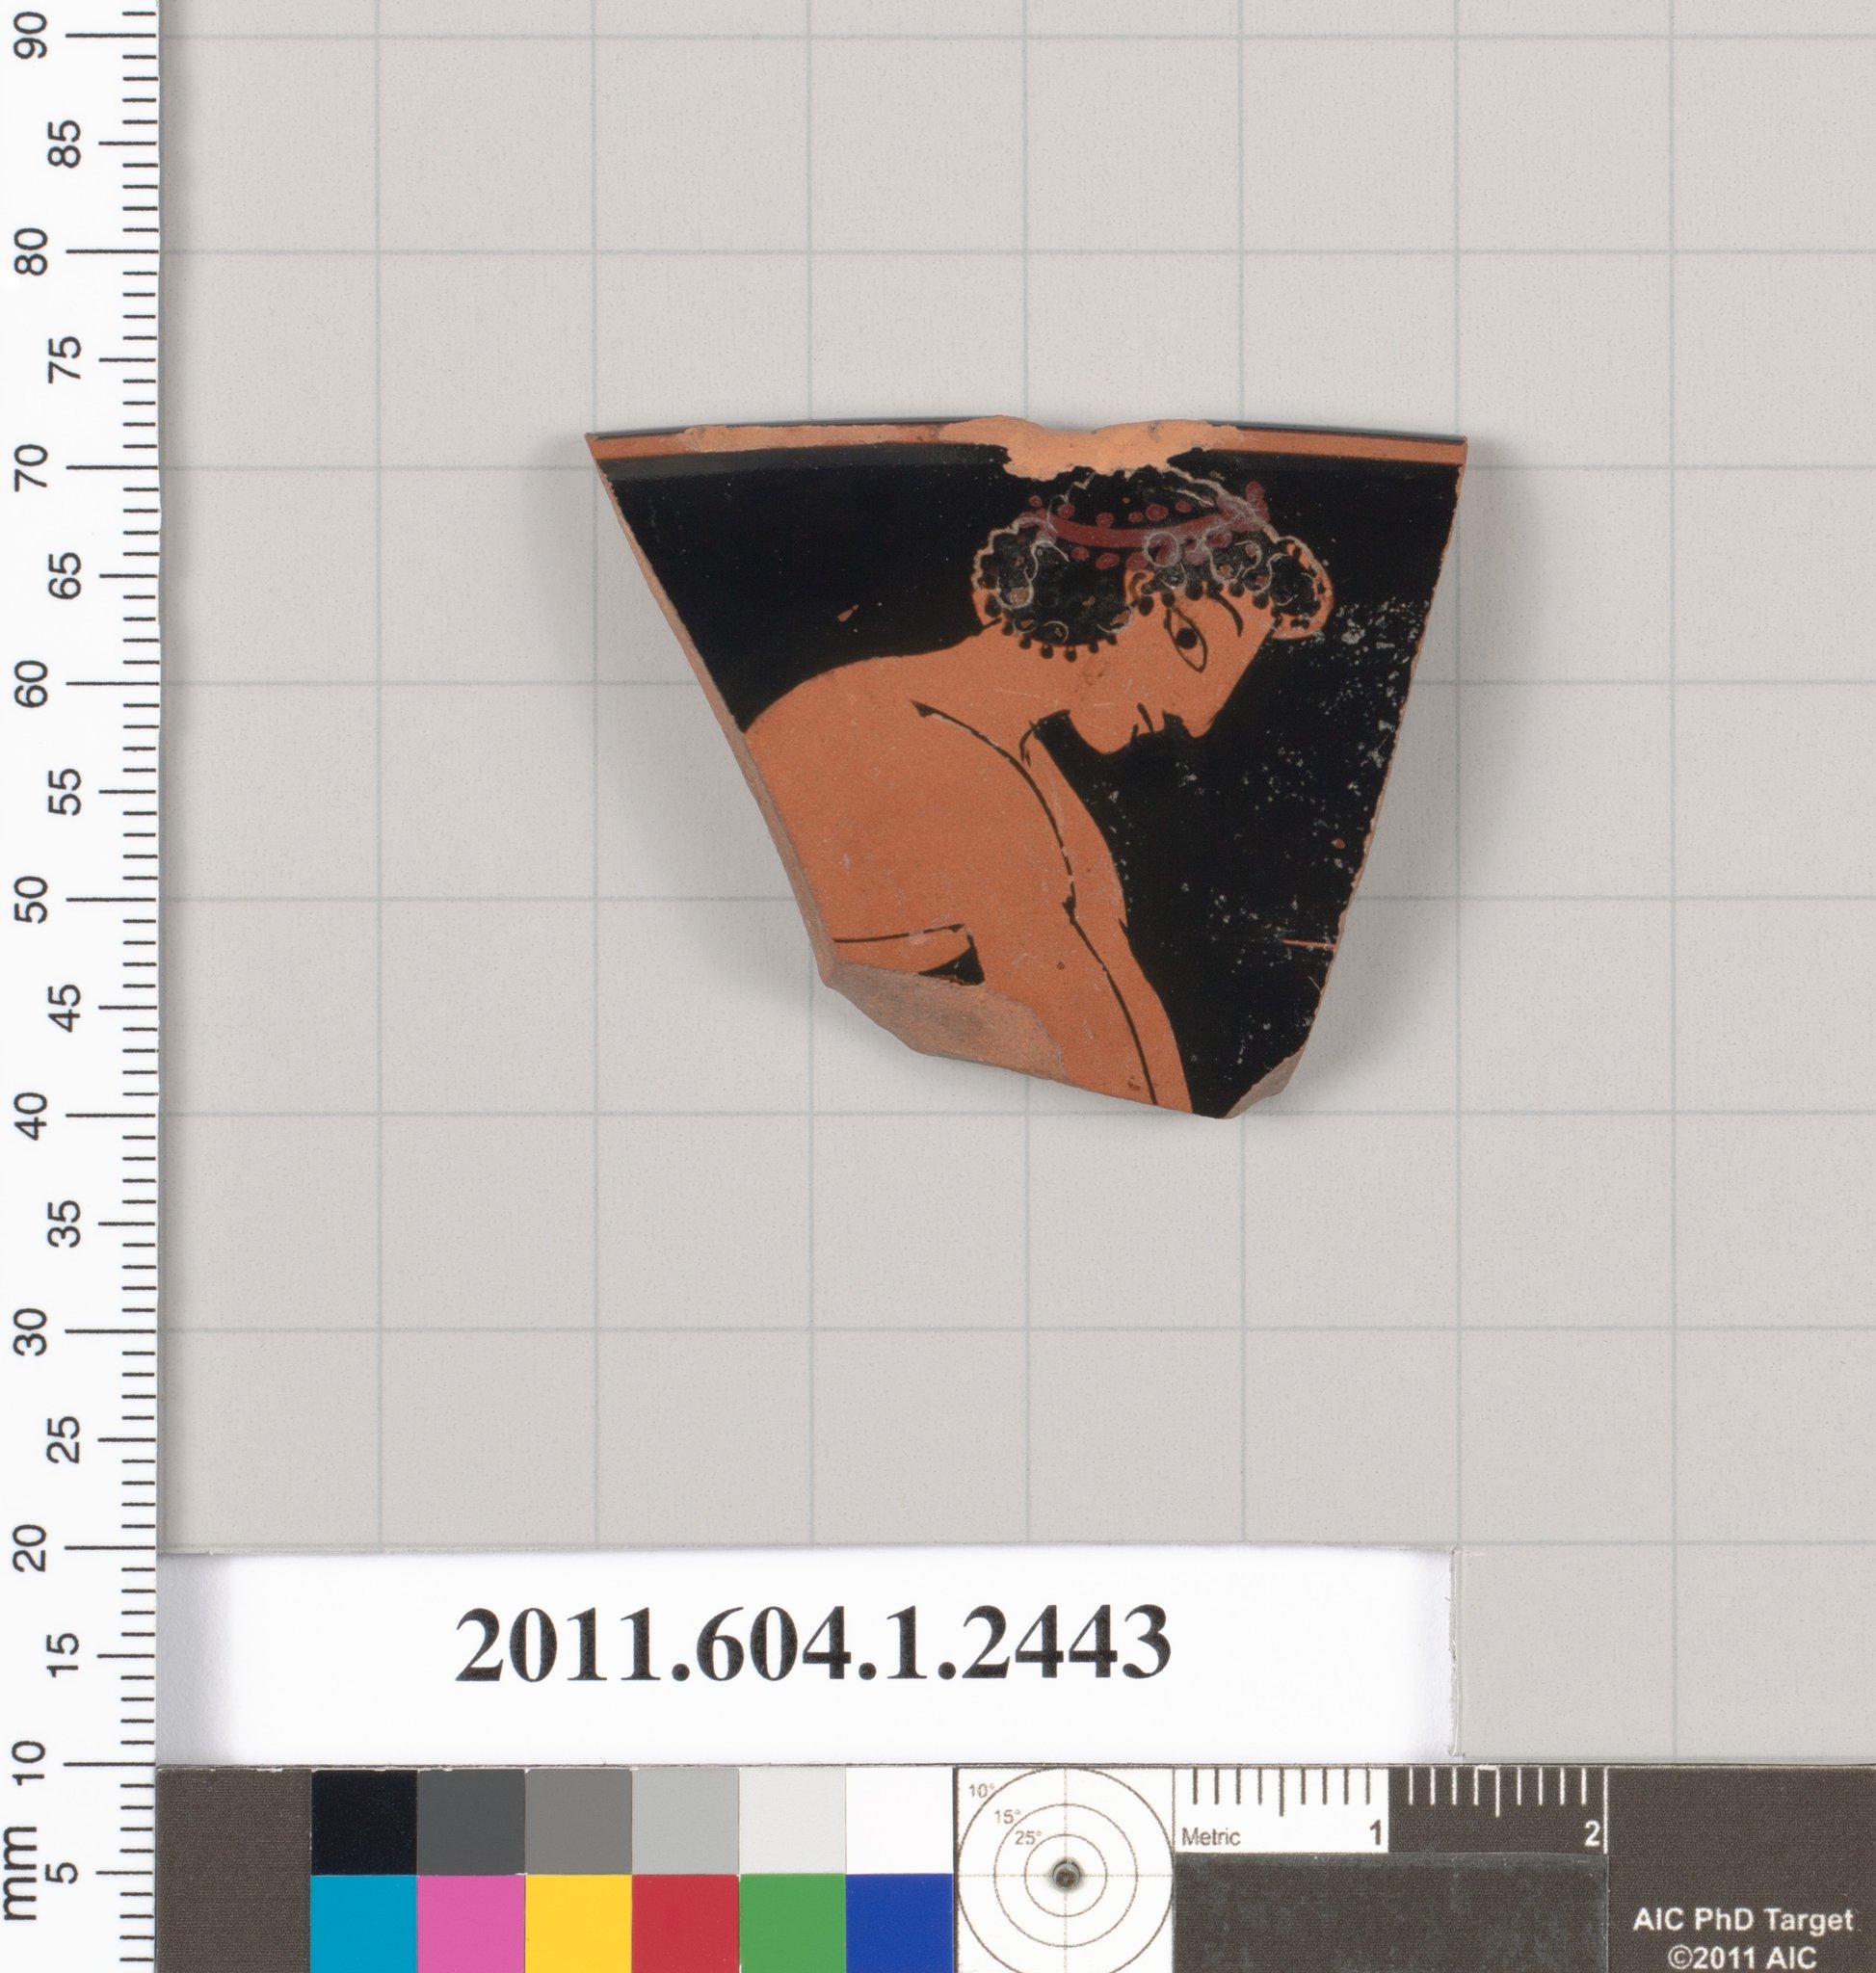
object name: kylix fragment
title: Terracotta rim fragment of a kylix (drinking cup)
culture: greek, attic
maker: ambrosios painter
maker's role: artist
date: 520-500 BCE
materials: terracotta